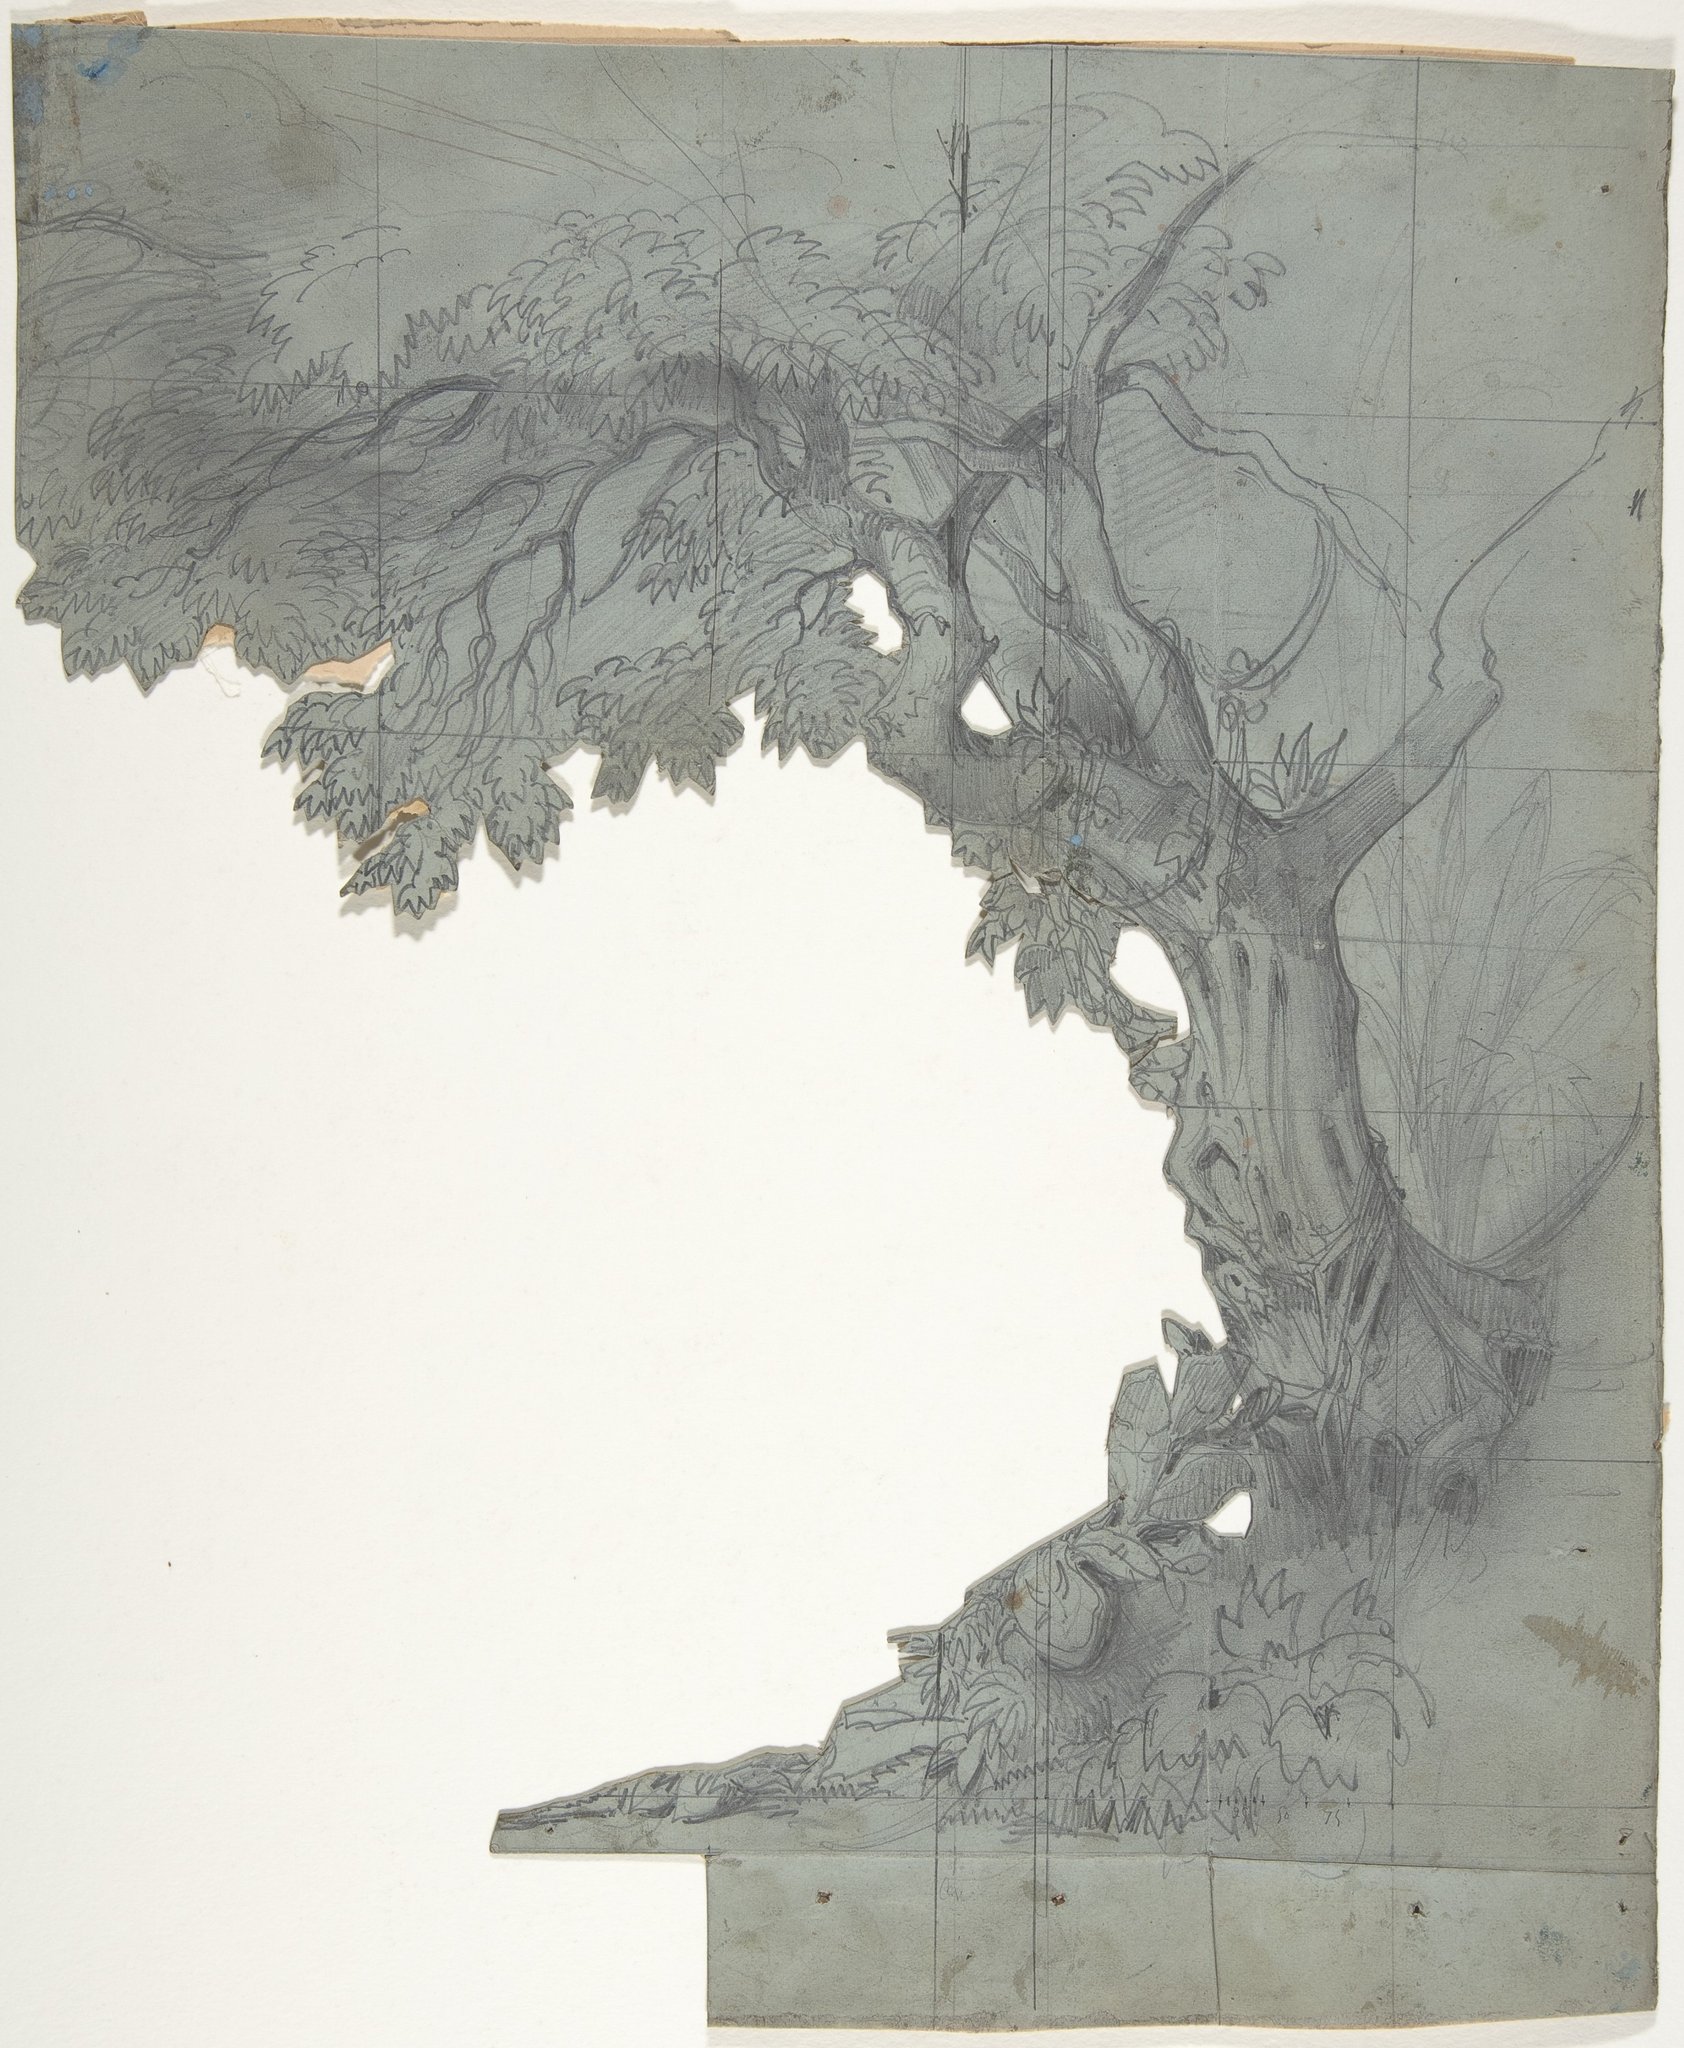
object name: drawing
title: Design for a Stage Set at the Opéra, Paris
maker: eugène cicéri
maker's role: artist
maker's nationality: french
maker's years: 1813-1890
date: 1830-1890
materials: graphite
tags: trees,stage design